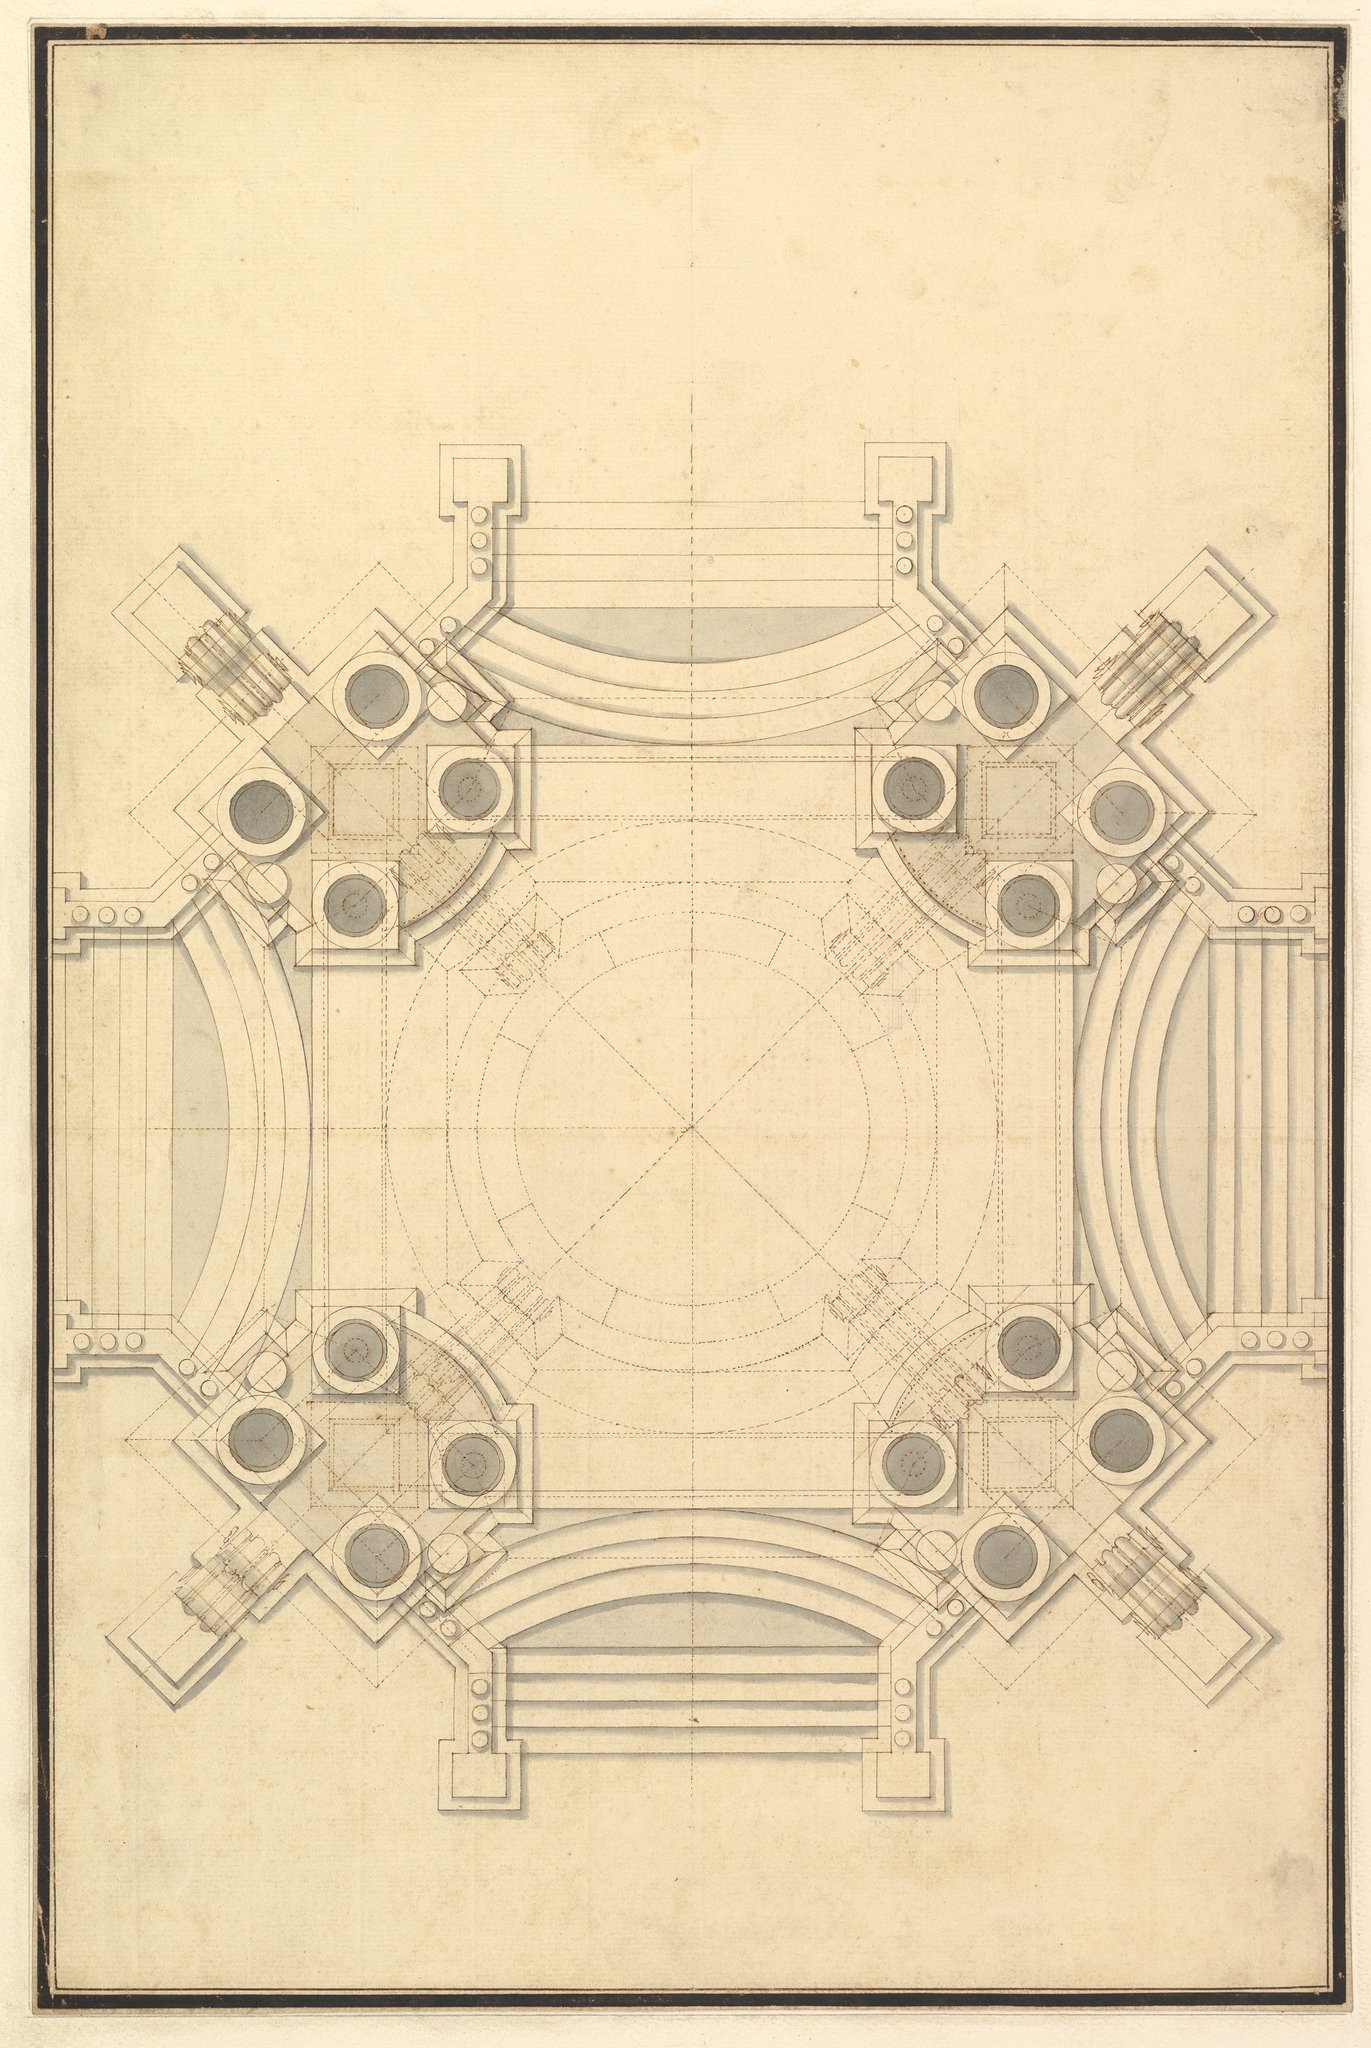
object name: drawing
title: Ground Plan for Catafalque for Johann Wilhelm, Count Palatine of the Rhine (d. 1716)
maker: giuseppe galli bibiena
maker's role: artist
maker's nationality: italian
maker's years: 1696-1756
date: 1716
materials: ink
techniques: pen, wash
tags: architecture